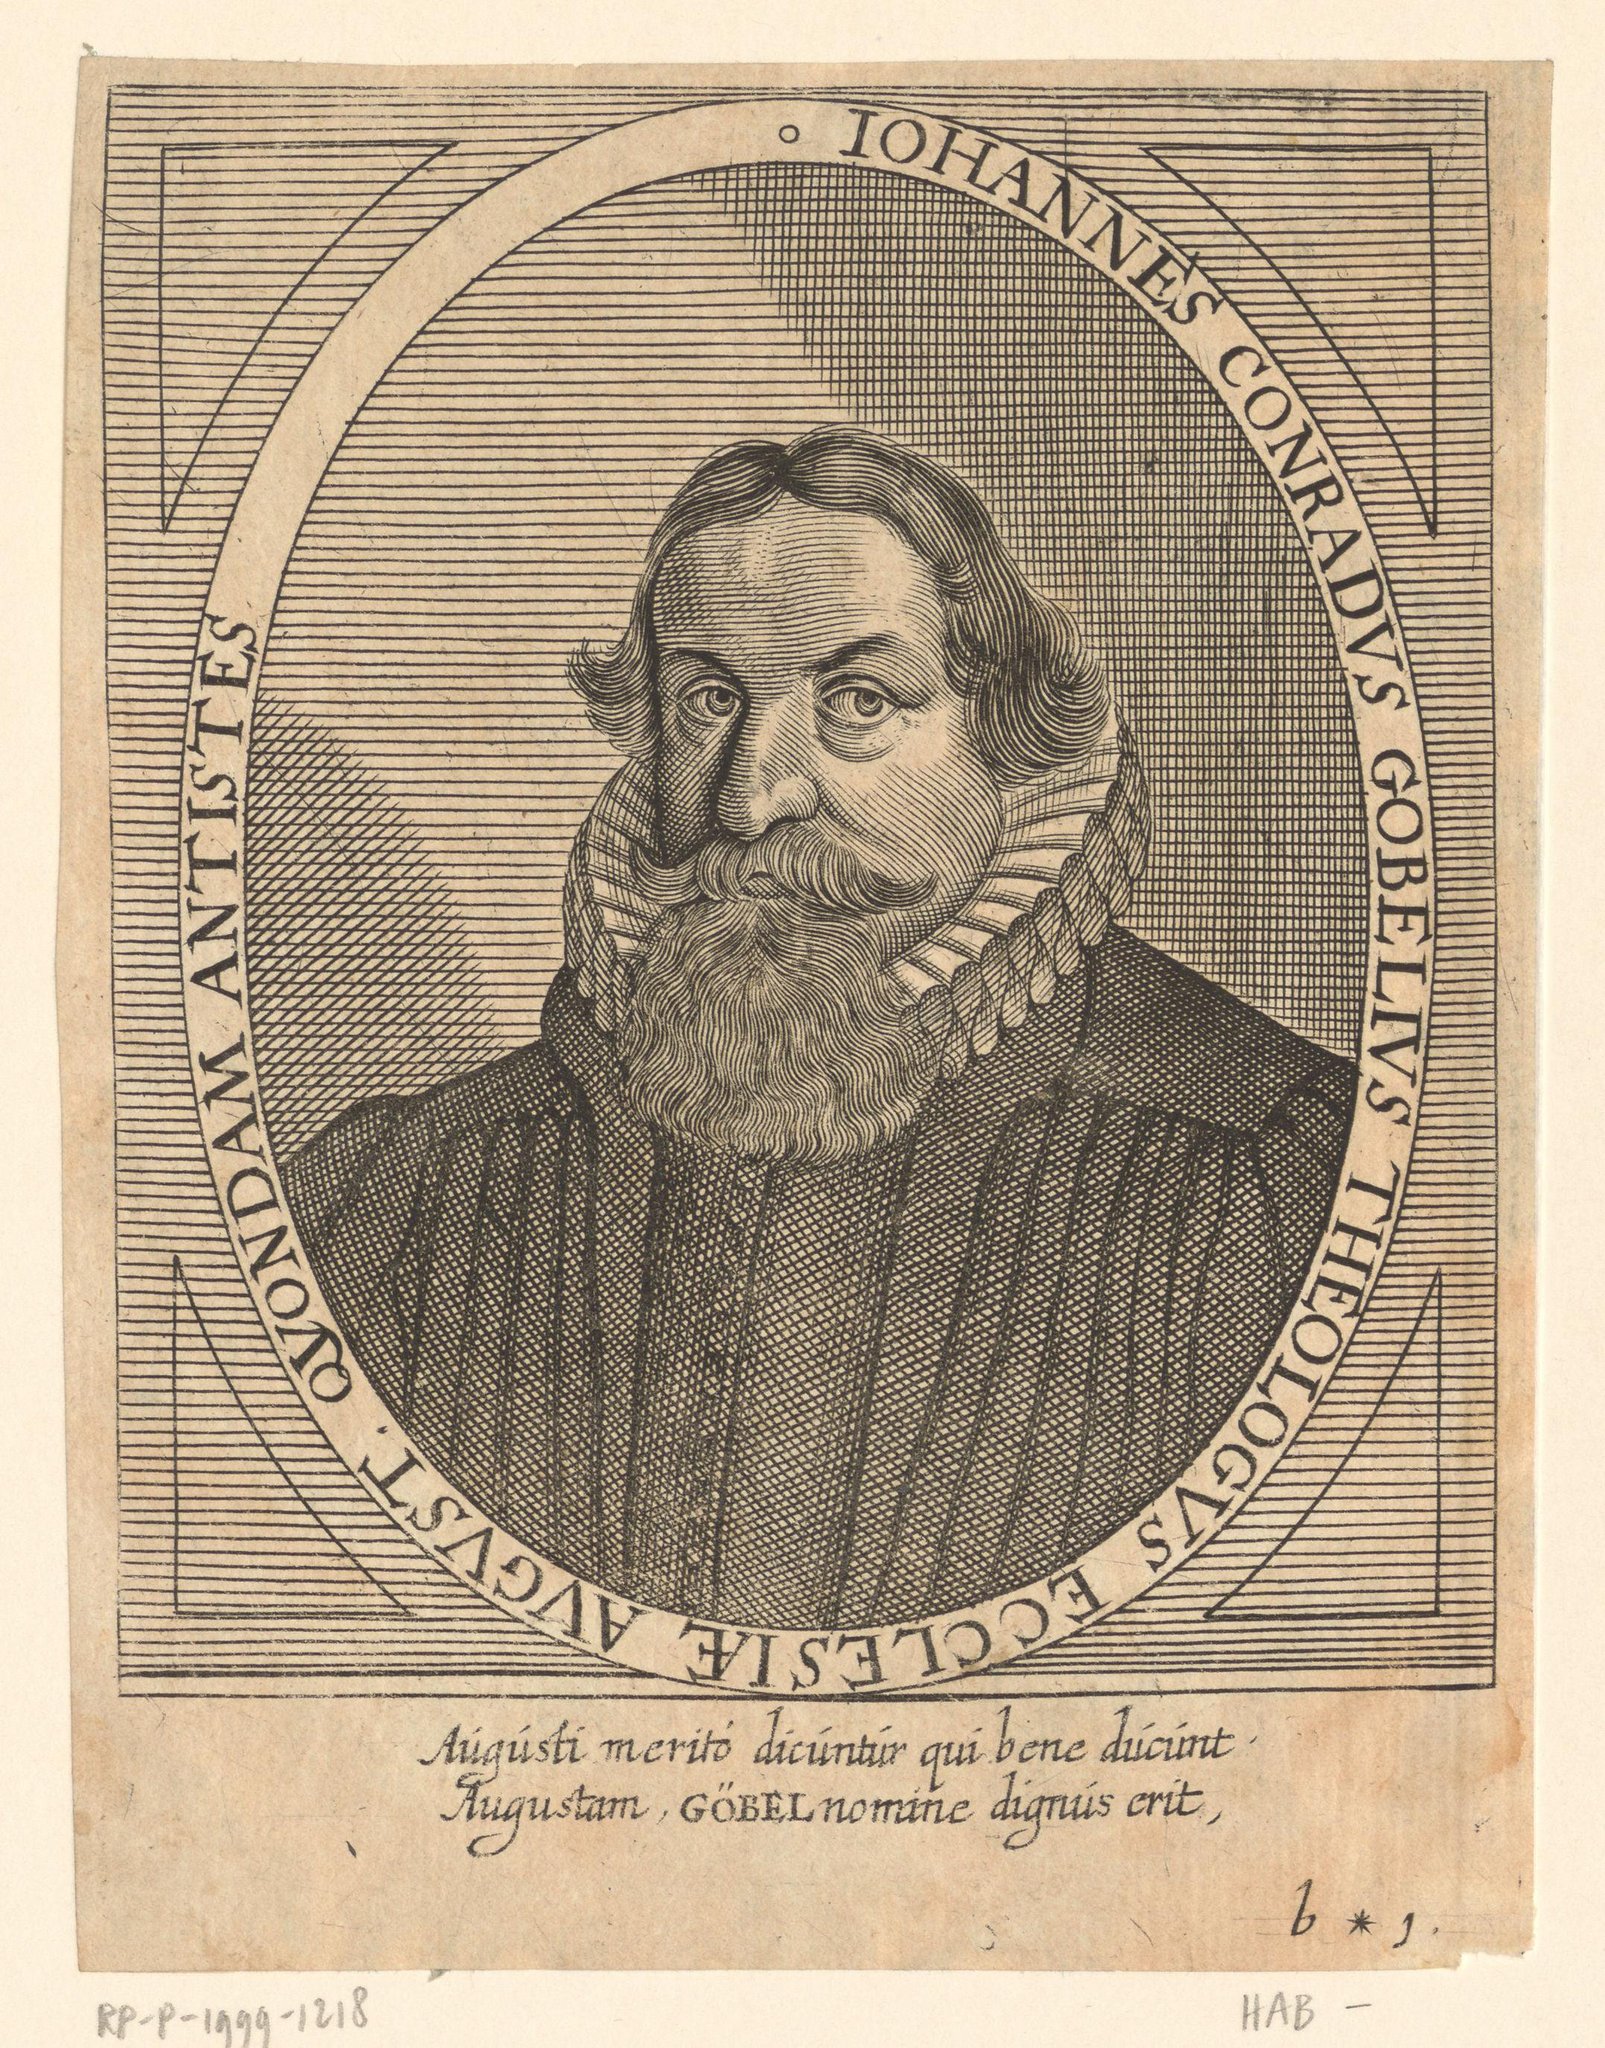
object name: print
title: Portret van Johann Conrad Göbel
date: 1654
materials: paper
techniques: engraving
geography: heidelberg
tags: augsburg, theologian, historical persons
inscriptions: collector's mark: Lugt 2228, collector's mark: Lugt 2760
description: Prent uit: Boissard, Jean Jacques. Bibliotheca chalcographica hoc est virtute et eruditione clarorum virorum imagines. Heidelberg: Johann Ammon, 1654, dl. 9.